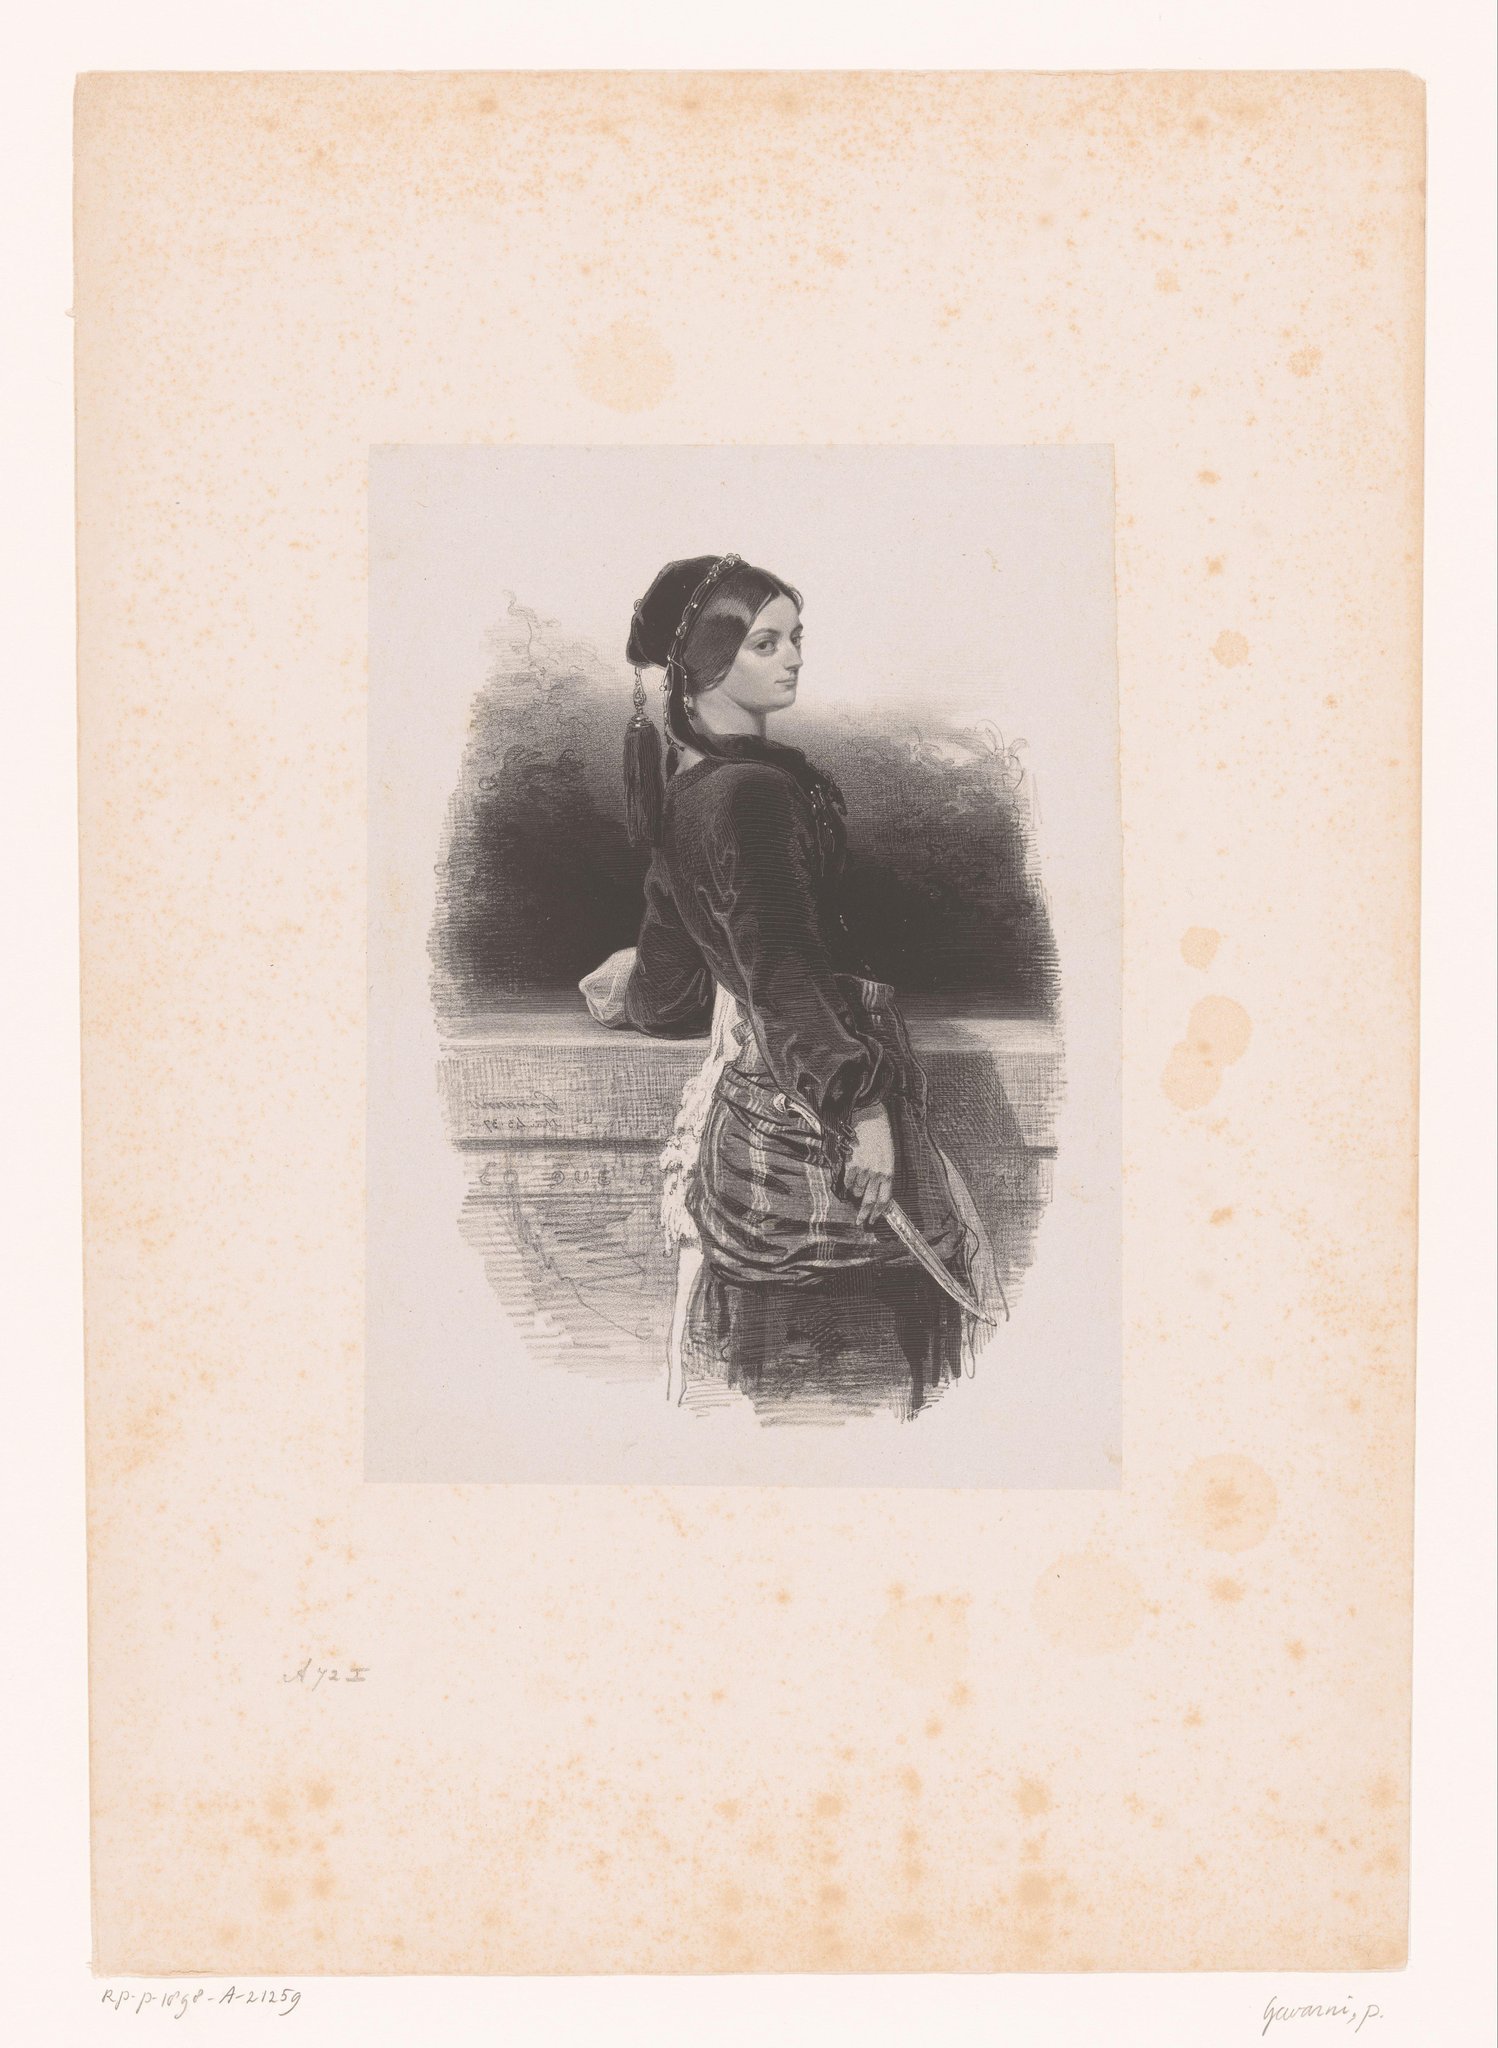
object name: book illustration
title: Portret van Mélanie Waldor als Gulnare uit Le Corsaire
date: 1843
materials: paper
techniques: lithograph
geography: paris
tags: paris, historical persons, slavery; serfs and enslaved persons, portrait of actor, actress, stage costume - cc - female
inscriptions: collector's mark: Lugt 964, collector's mark: Lugt 2228a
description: Mélanie Waldor in de rol van Gulnare, een Perzische tot slaaf gemaakte vrouw die een hoofdrol speelt in het ballet Le Corsaire.